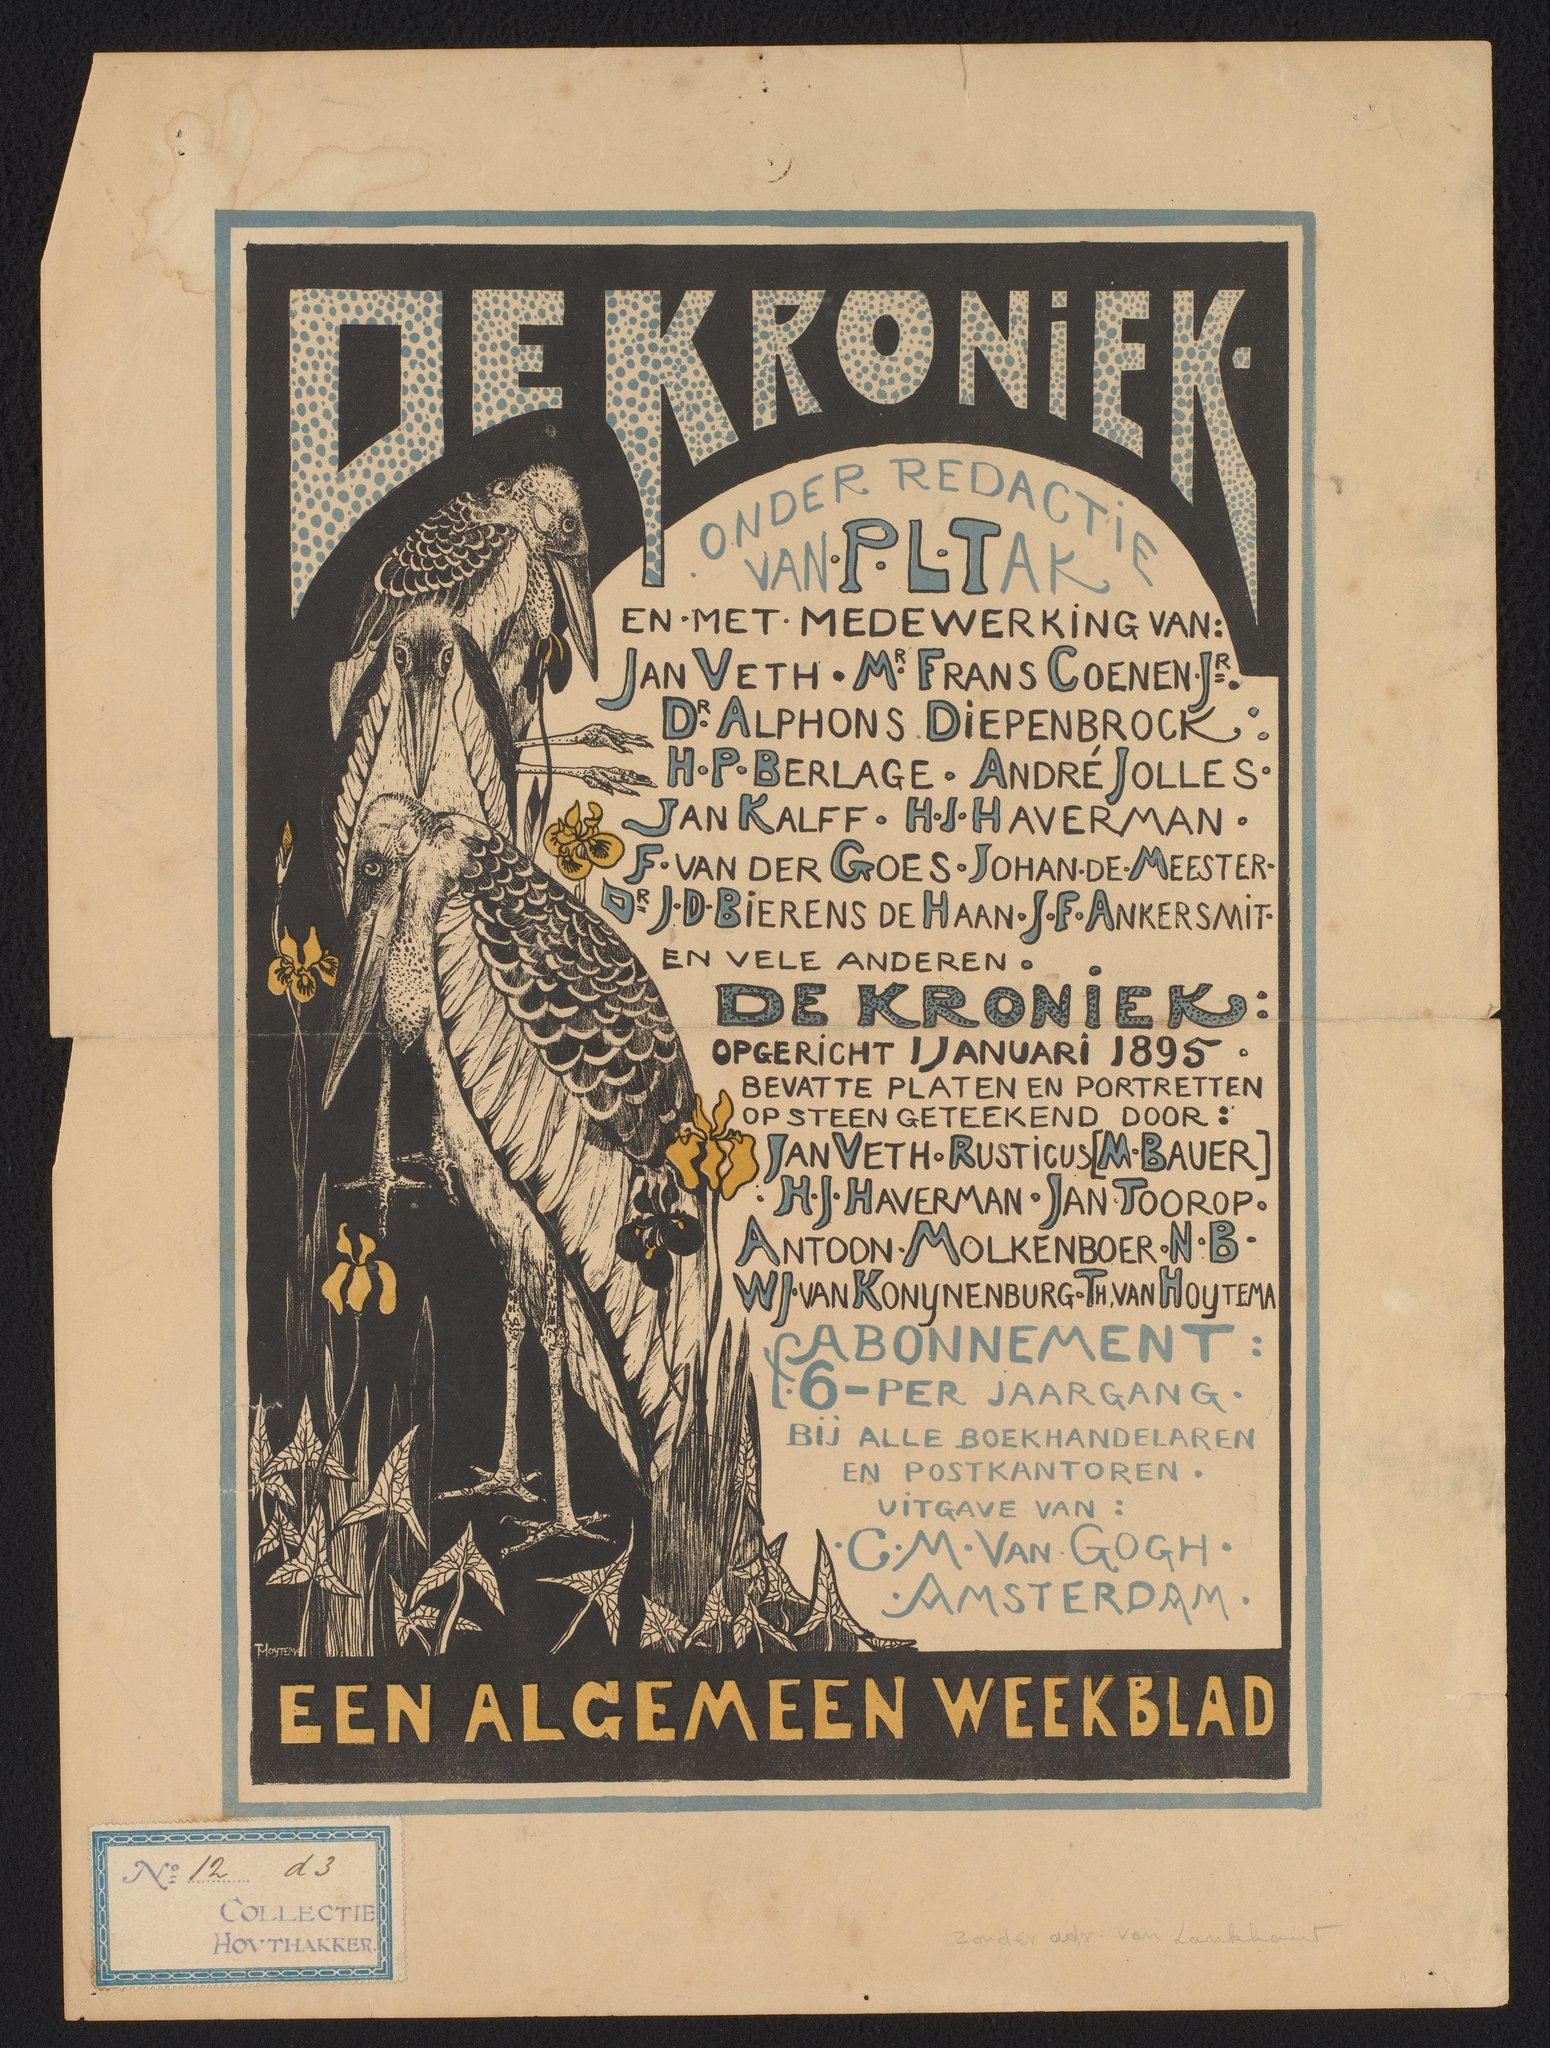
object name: poster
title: Affiche ter aankondiging van het tijdschrift 'De kroniek'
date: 1895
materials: paper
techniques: lithograph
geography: amsterdam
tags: birds, flowers: lily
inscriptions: collector's mark: Lugt 2166, collector's mark: ‘No. 12 d3, Collectie Houthakker’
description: Affiche ter promotie van: Tak, P.L. (red.). De kroniek, een algemeen weekblad. Amstserdam: C.M. van Gogh, 1895.